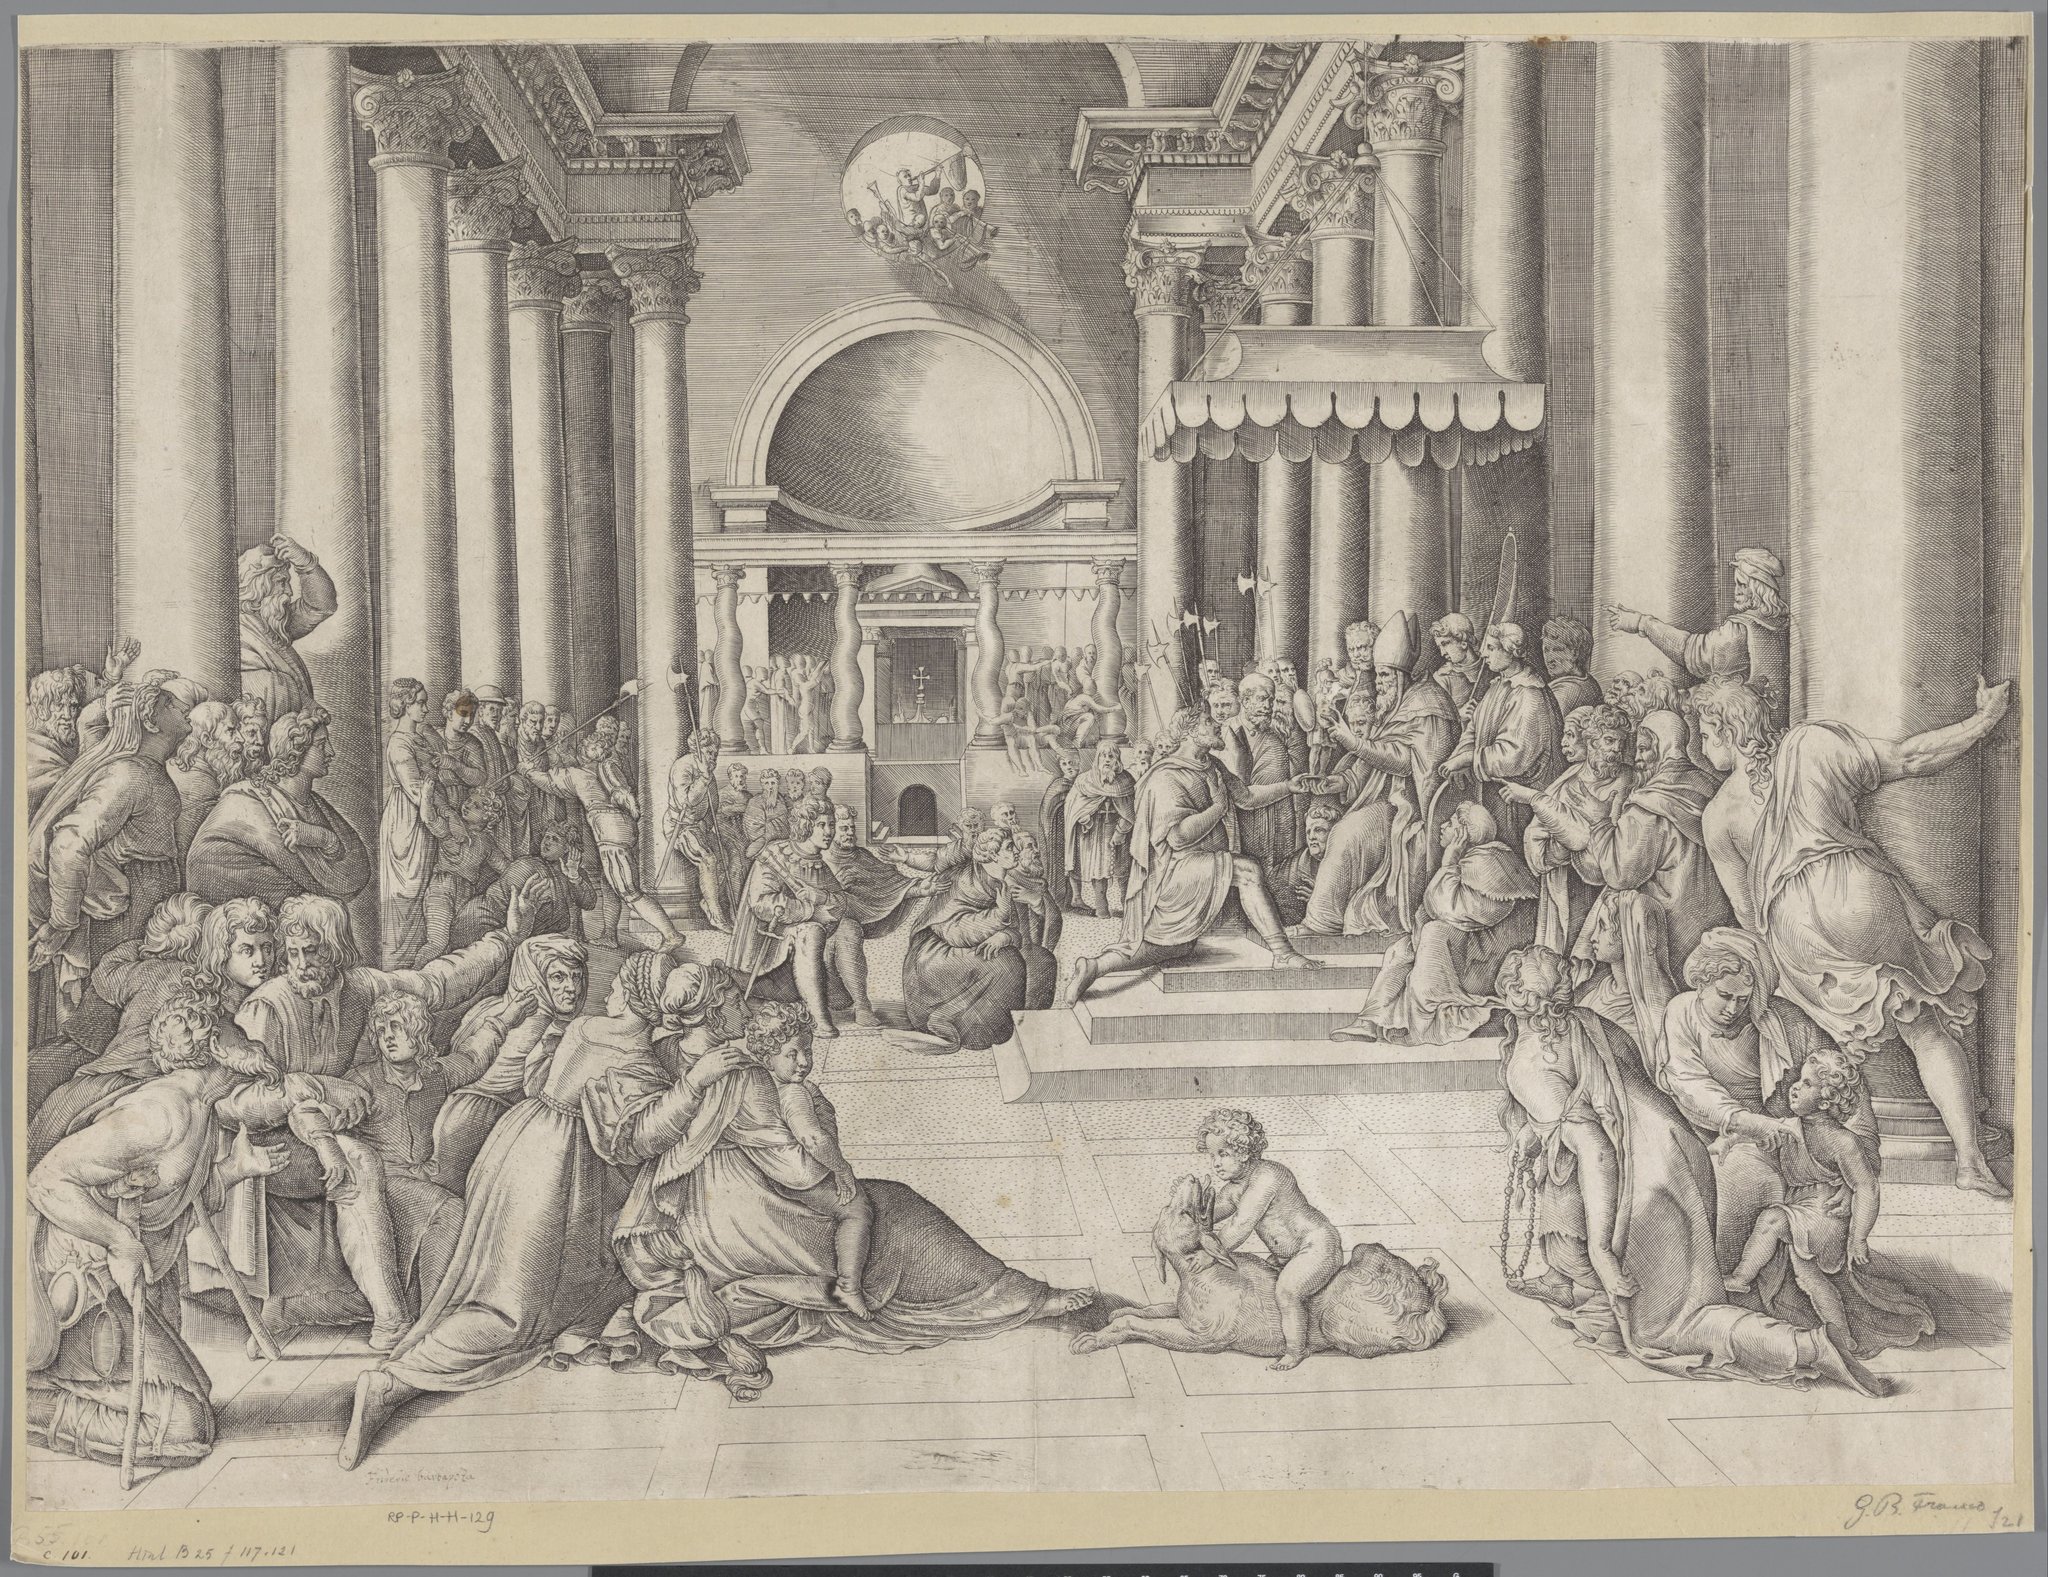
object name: print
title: Keizer Constantijn overhandigt de stad Rome aan de paus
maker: battista franco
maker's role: draughtsman, painter, print maker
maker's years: 1510-1561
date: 1520-1561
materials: paper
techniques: engraving, etching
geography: italy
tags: pope, the donation of constantine (the donation of rome): st. constantine, kneeling before pope sylvester, hands over a document, rome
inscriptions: collector's mark: Lugt 11, collector's mark: Lugt 10, inscription: ‘Frideric barbaycza’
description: Zicht in de Sint-Pietersbasiliek waar Keizer Constantijn de stad Rome overhandigt aan paus Silvester I. Ze worden omringd door een grote groep toeschouwers.